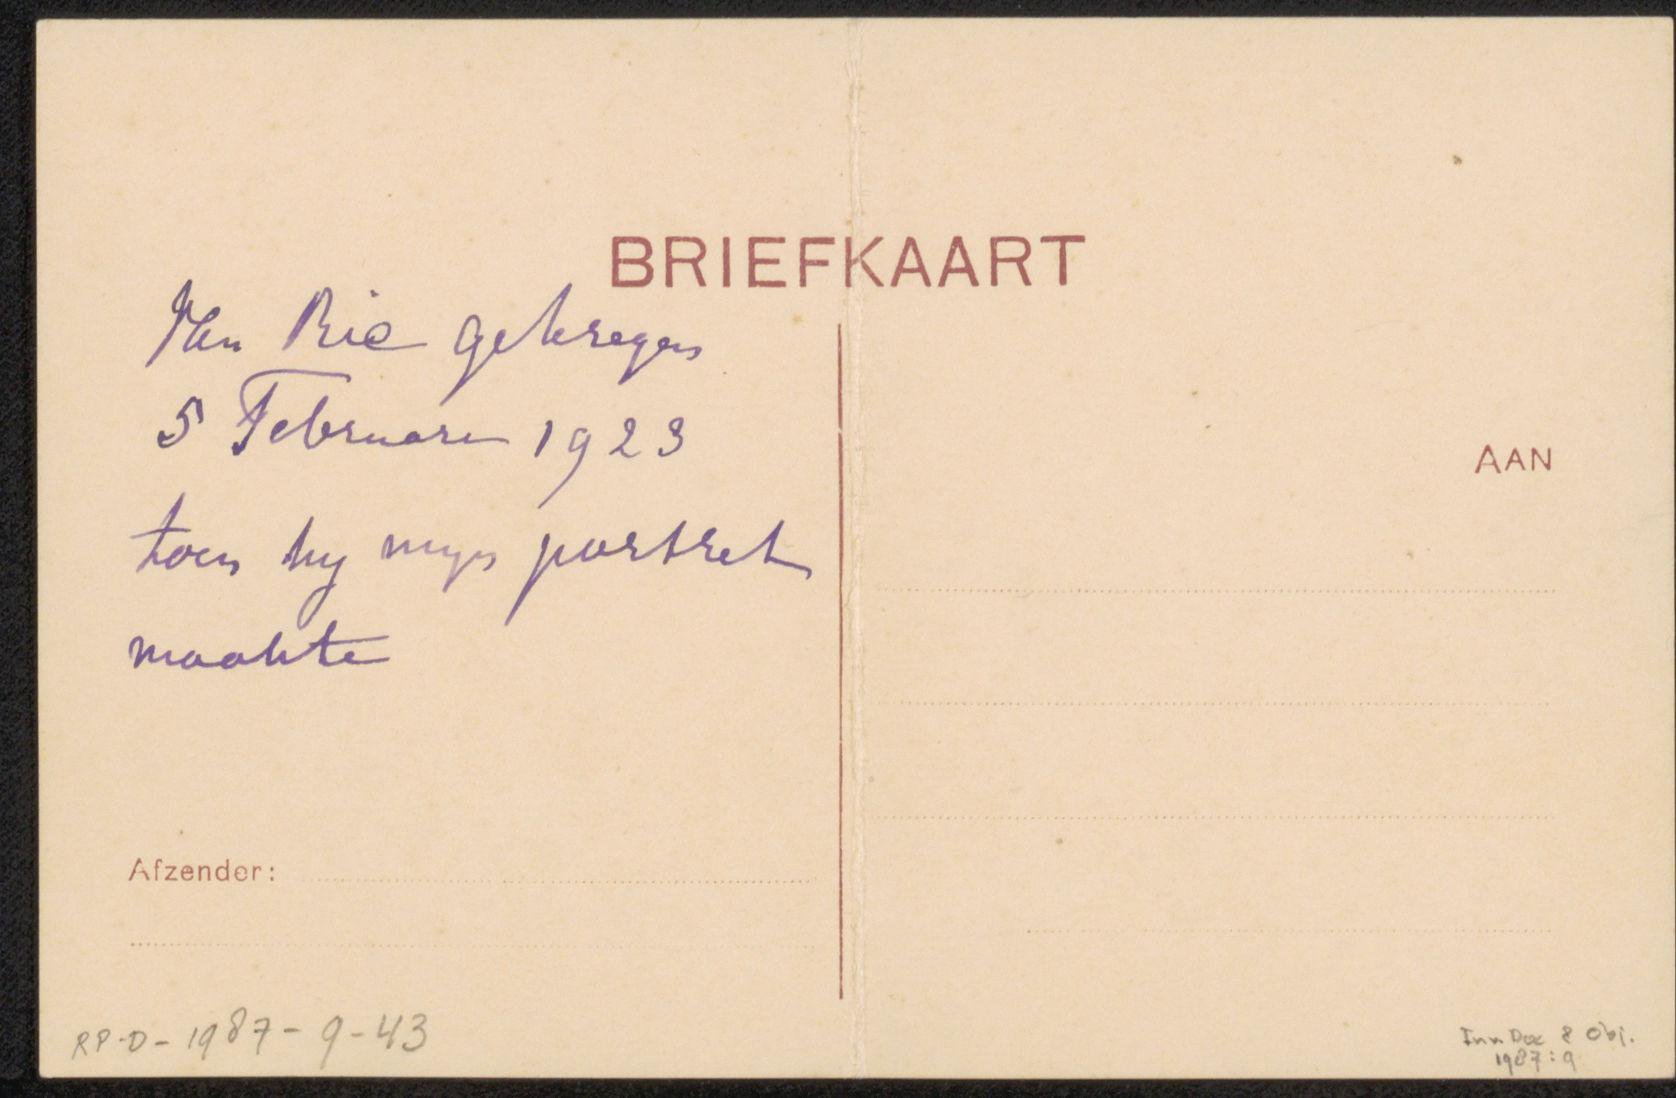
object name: postcard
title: Briefkaart aan Ina van Eibergen Santhagens-Waller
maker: richard nicolaüs roland holst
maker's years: 1868-1938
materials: cardboard, ink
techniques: pen, writing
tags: richard wagner, historical persons (portraits and scenes from the life)